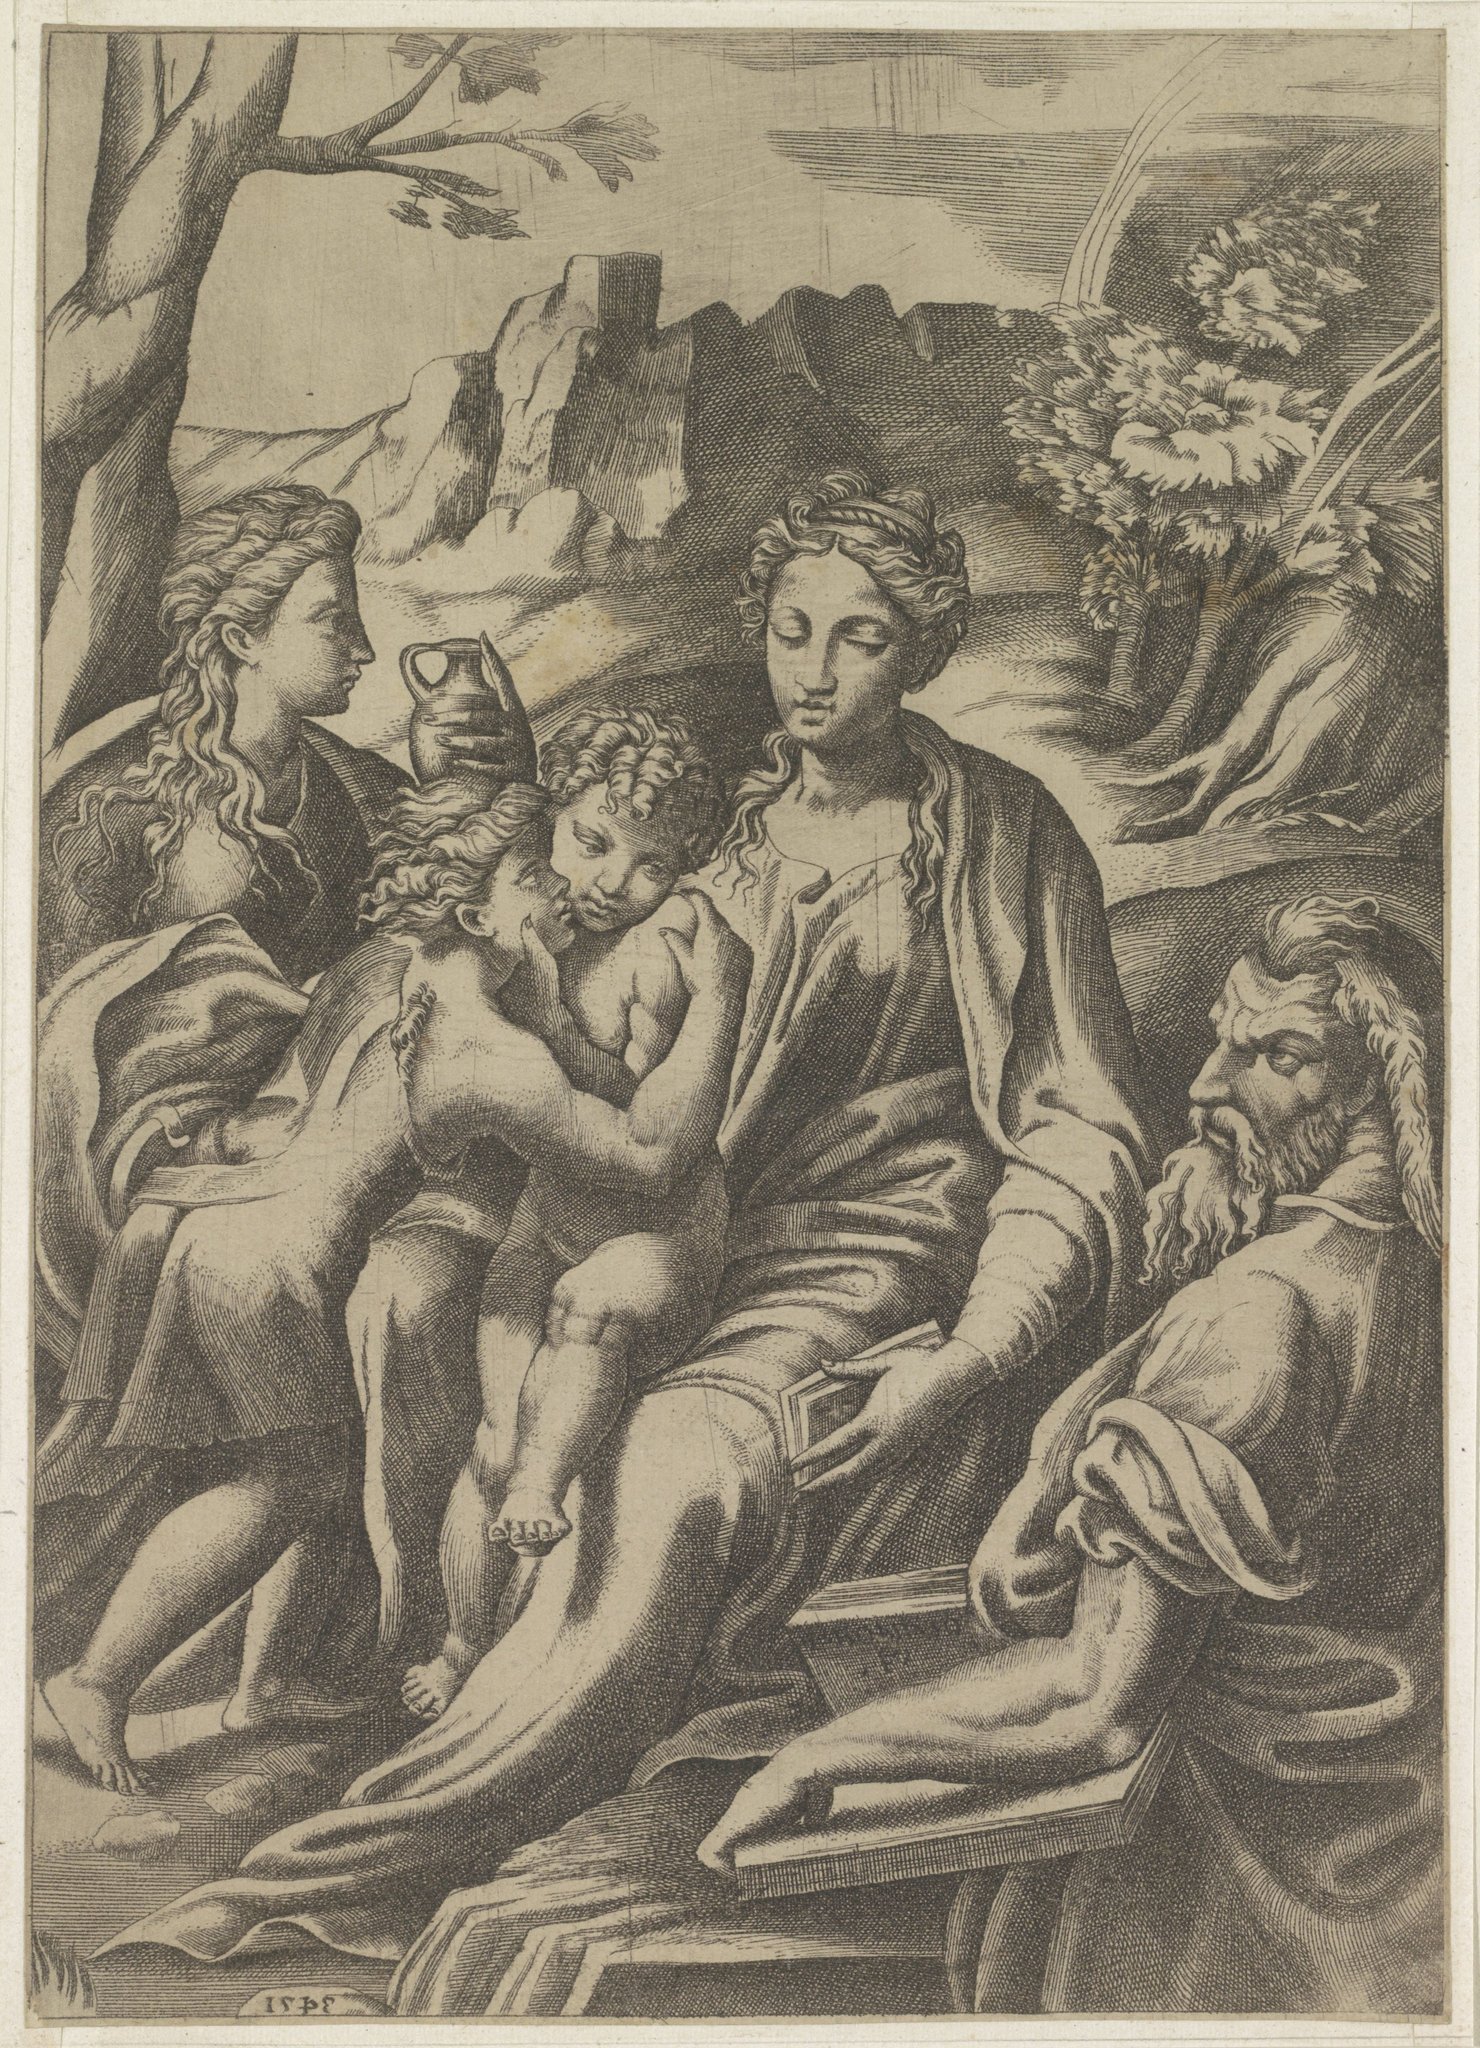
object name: print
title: Heilige Familie met de jonge Johannes de Doper en Maria Magdalena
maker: giulio bonasone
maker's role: painter, print maker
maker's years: 1510-1576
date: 1543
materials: paper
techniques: engraving, etching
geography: italy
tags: holy family with john the baptist (as child), the penitent harlot mary magdalene; possible attributes: book (or scroll), crown, crown of thorns, crucifix, jar of ointment, mirror, musical instrument, palm-branch, rosary, scourge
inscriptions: collector's mark: Lugt 240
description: De Heilige Familie met de jonge Johannes de Doper en Maria Magdalena in een landschap. Jozef zit rechts.